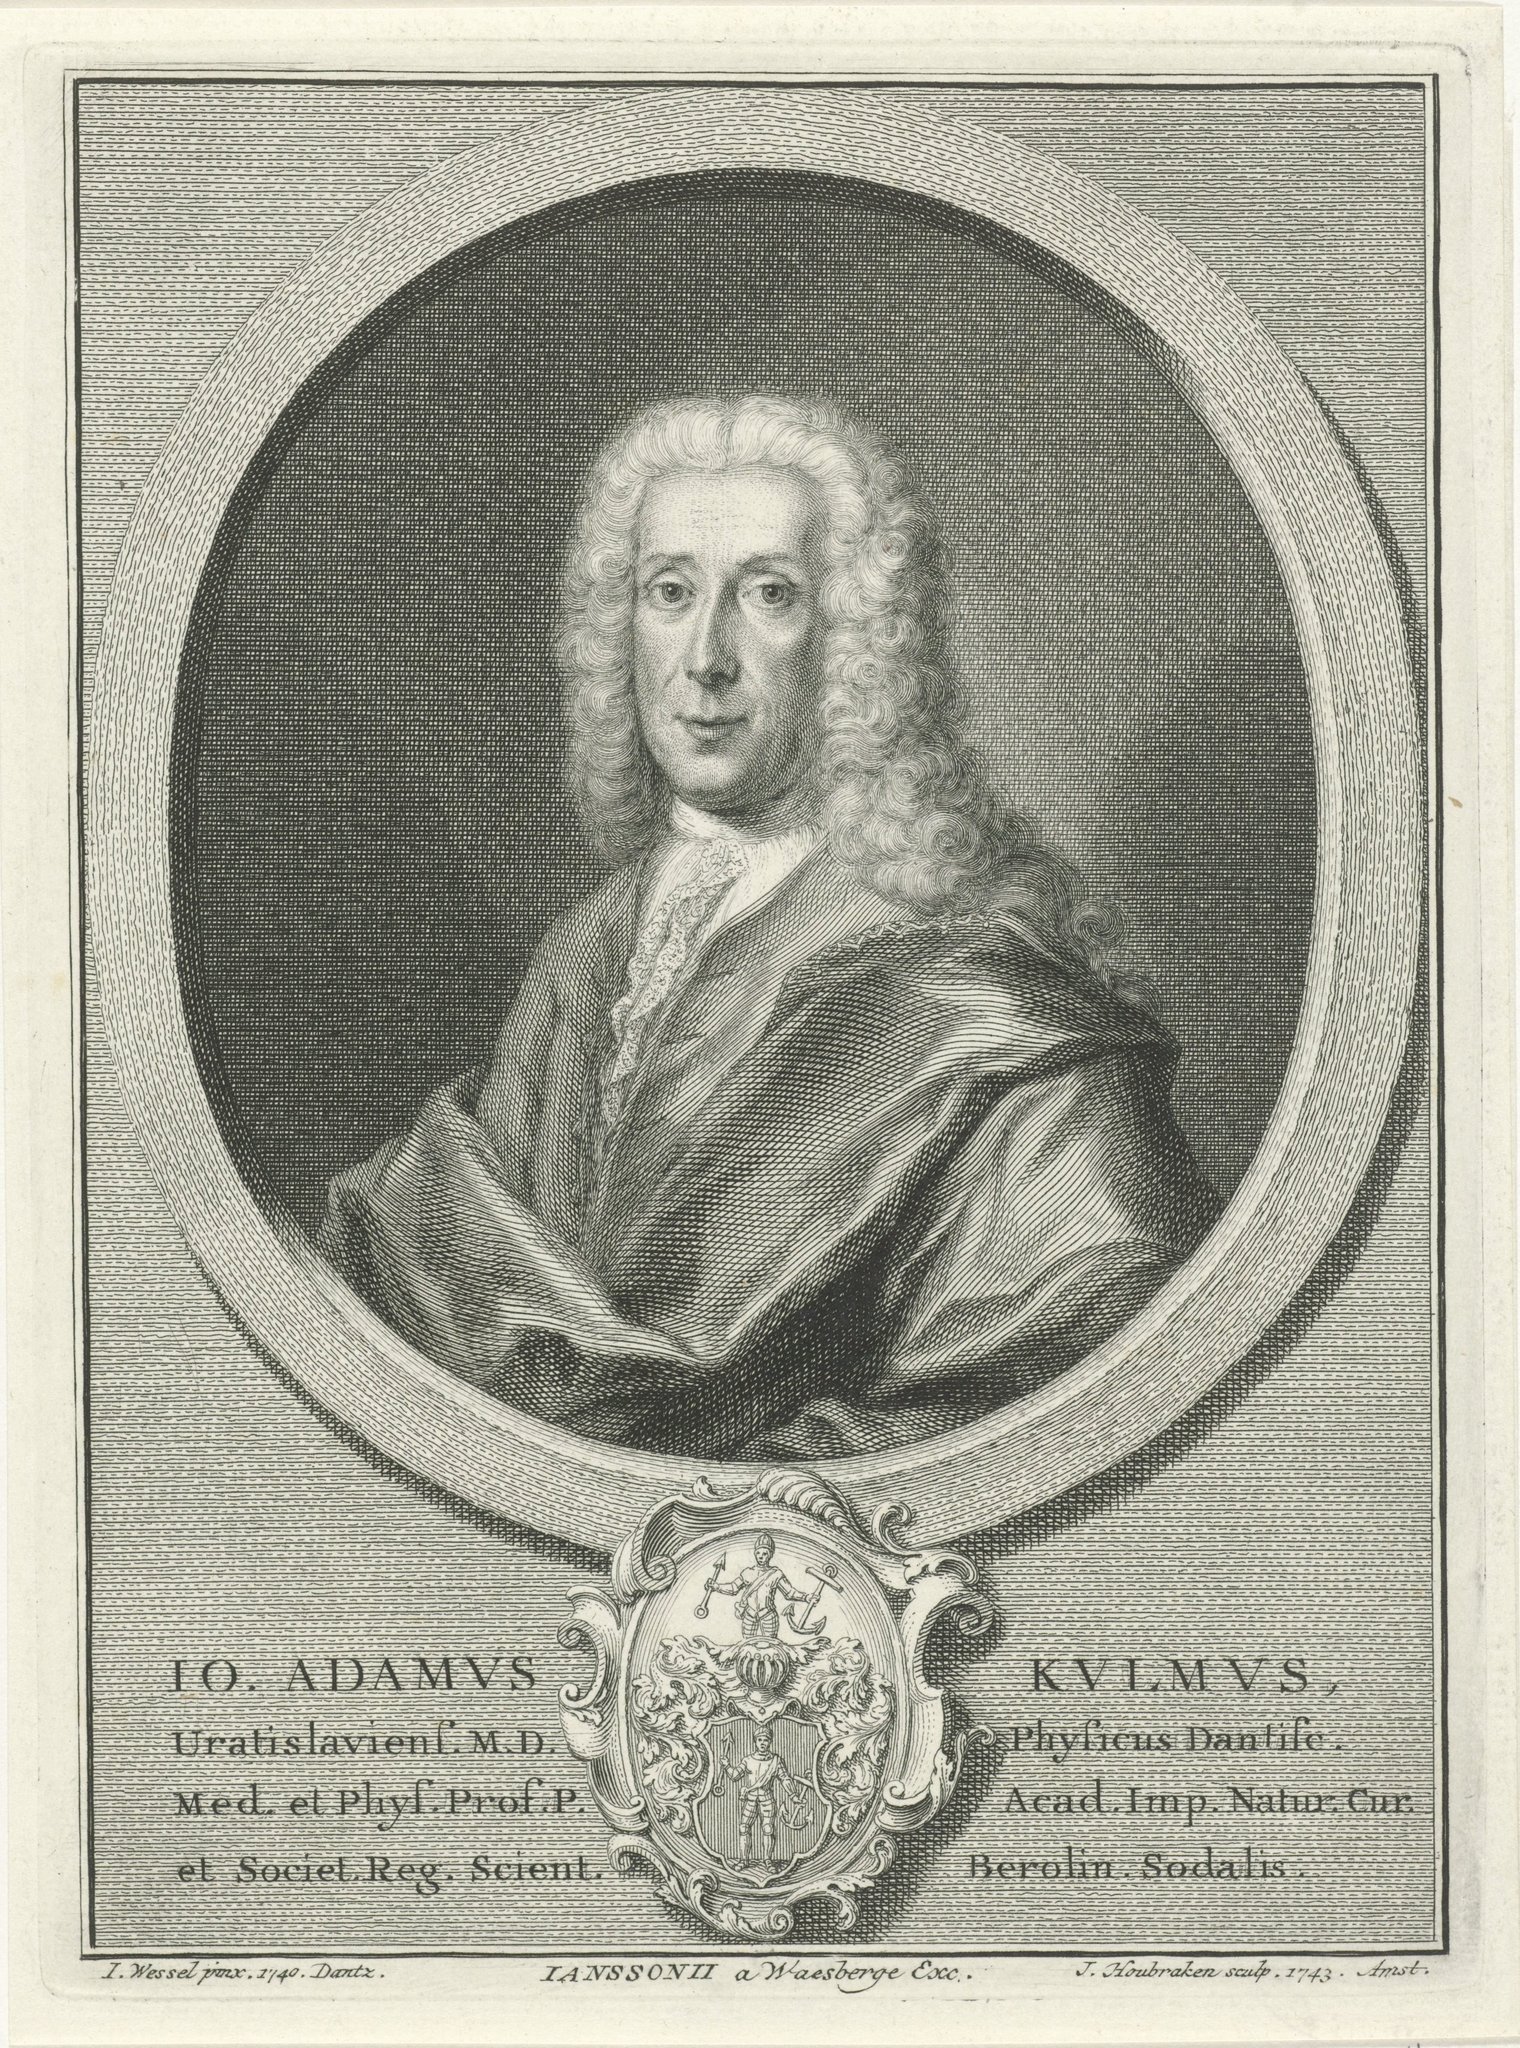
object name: print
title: Portret van Johan Adam Kulmus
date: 1743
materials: paper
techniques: engraving, etching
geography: amsterdam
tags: breslau, danzig, medicus, anatoom, johan adam kulmus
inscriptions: collector's mark: Lugt 240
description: Portret ten halven lijve naar links van Johan Adam Kulmus in een ovaal. Onderaan een wapen en een vierregelige tekst in het Latijn.